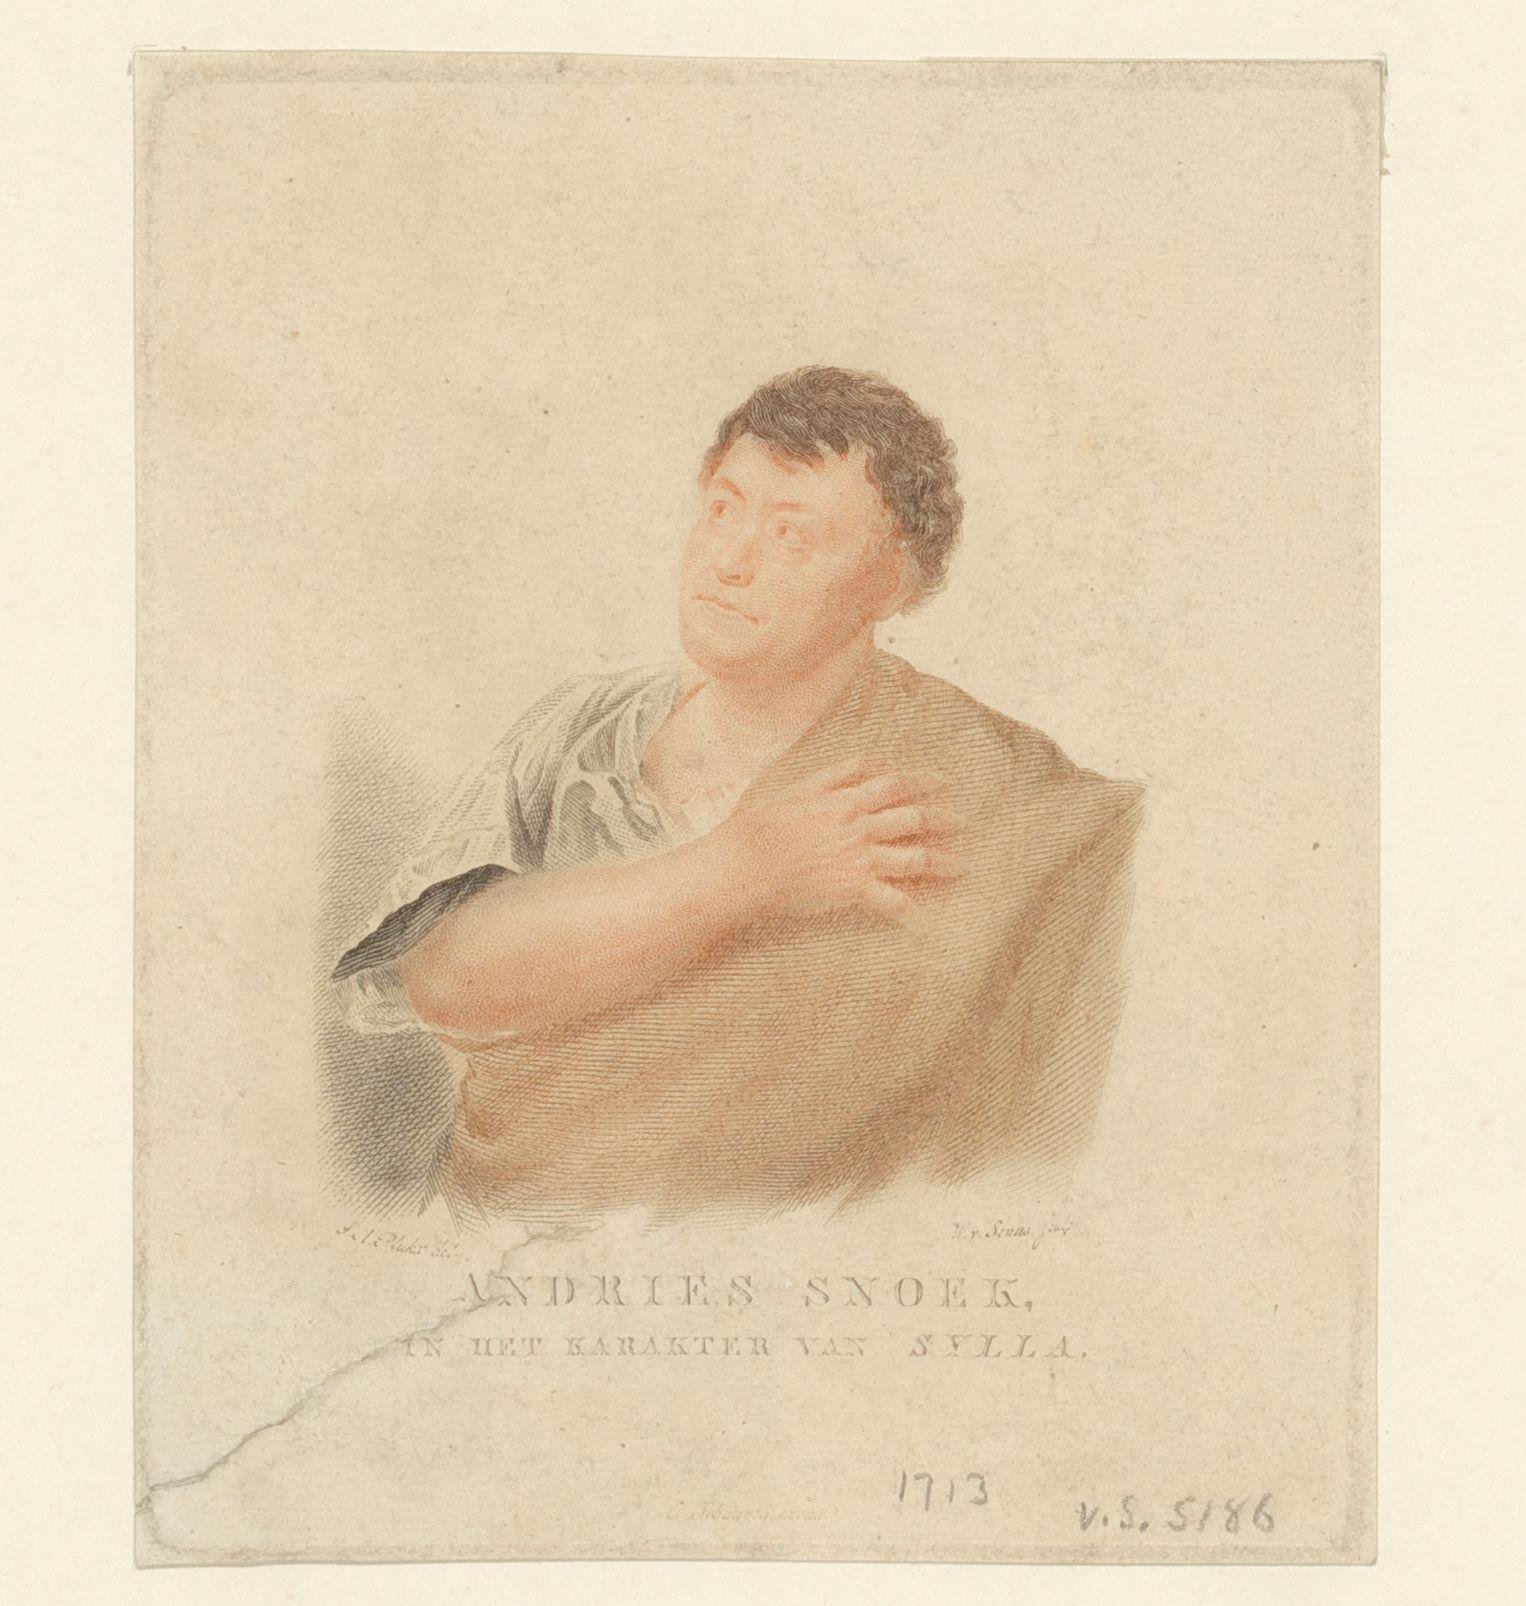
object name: print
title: Andries Snoek in het karakter van Sylla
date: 1824-1829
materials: paper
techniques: engraving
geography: amsterdam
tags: amsterdam, historical persons, portrait of actor, actress, actor (on the stage)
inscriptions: collector's mark: Lugt 1641, stamp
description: Prent in zwart gebruikt in: Almanak voor het Verstand en hart voor het Jaar 1824. Amsterdam: C. Schaares, s.a. [1825]. En in: Abraham Louis Barbaz. Gedenkzuil, voor Neêrlands hoogverdienstelyken tooneelkunstenaar Andries Snoek. Amsterdam: J.C. van Kesteren, 1829.